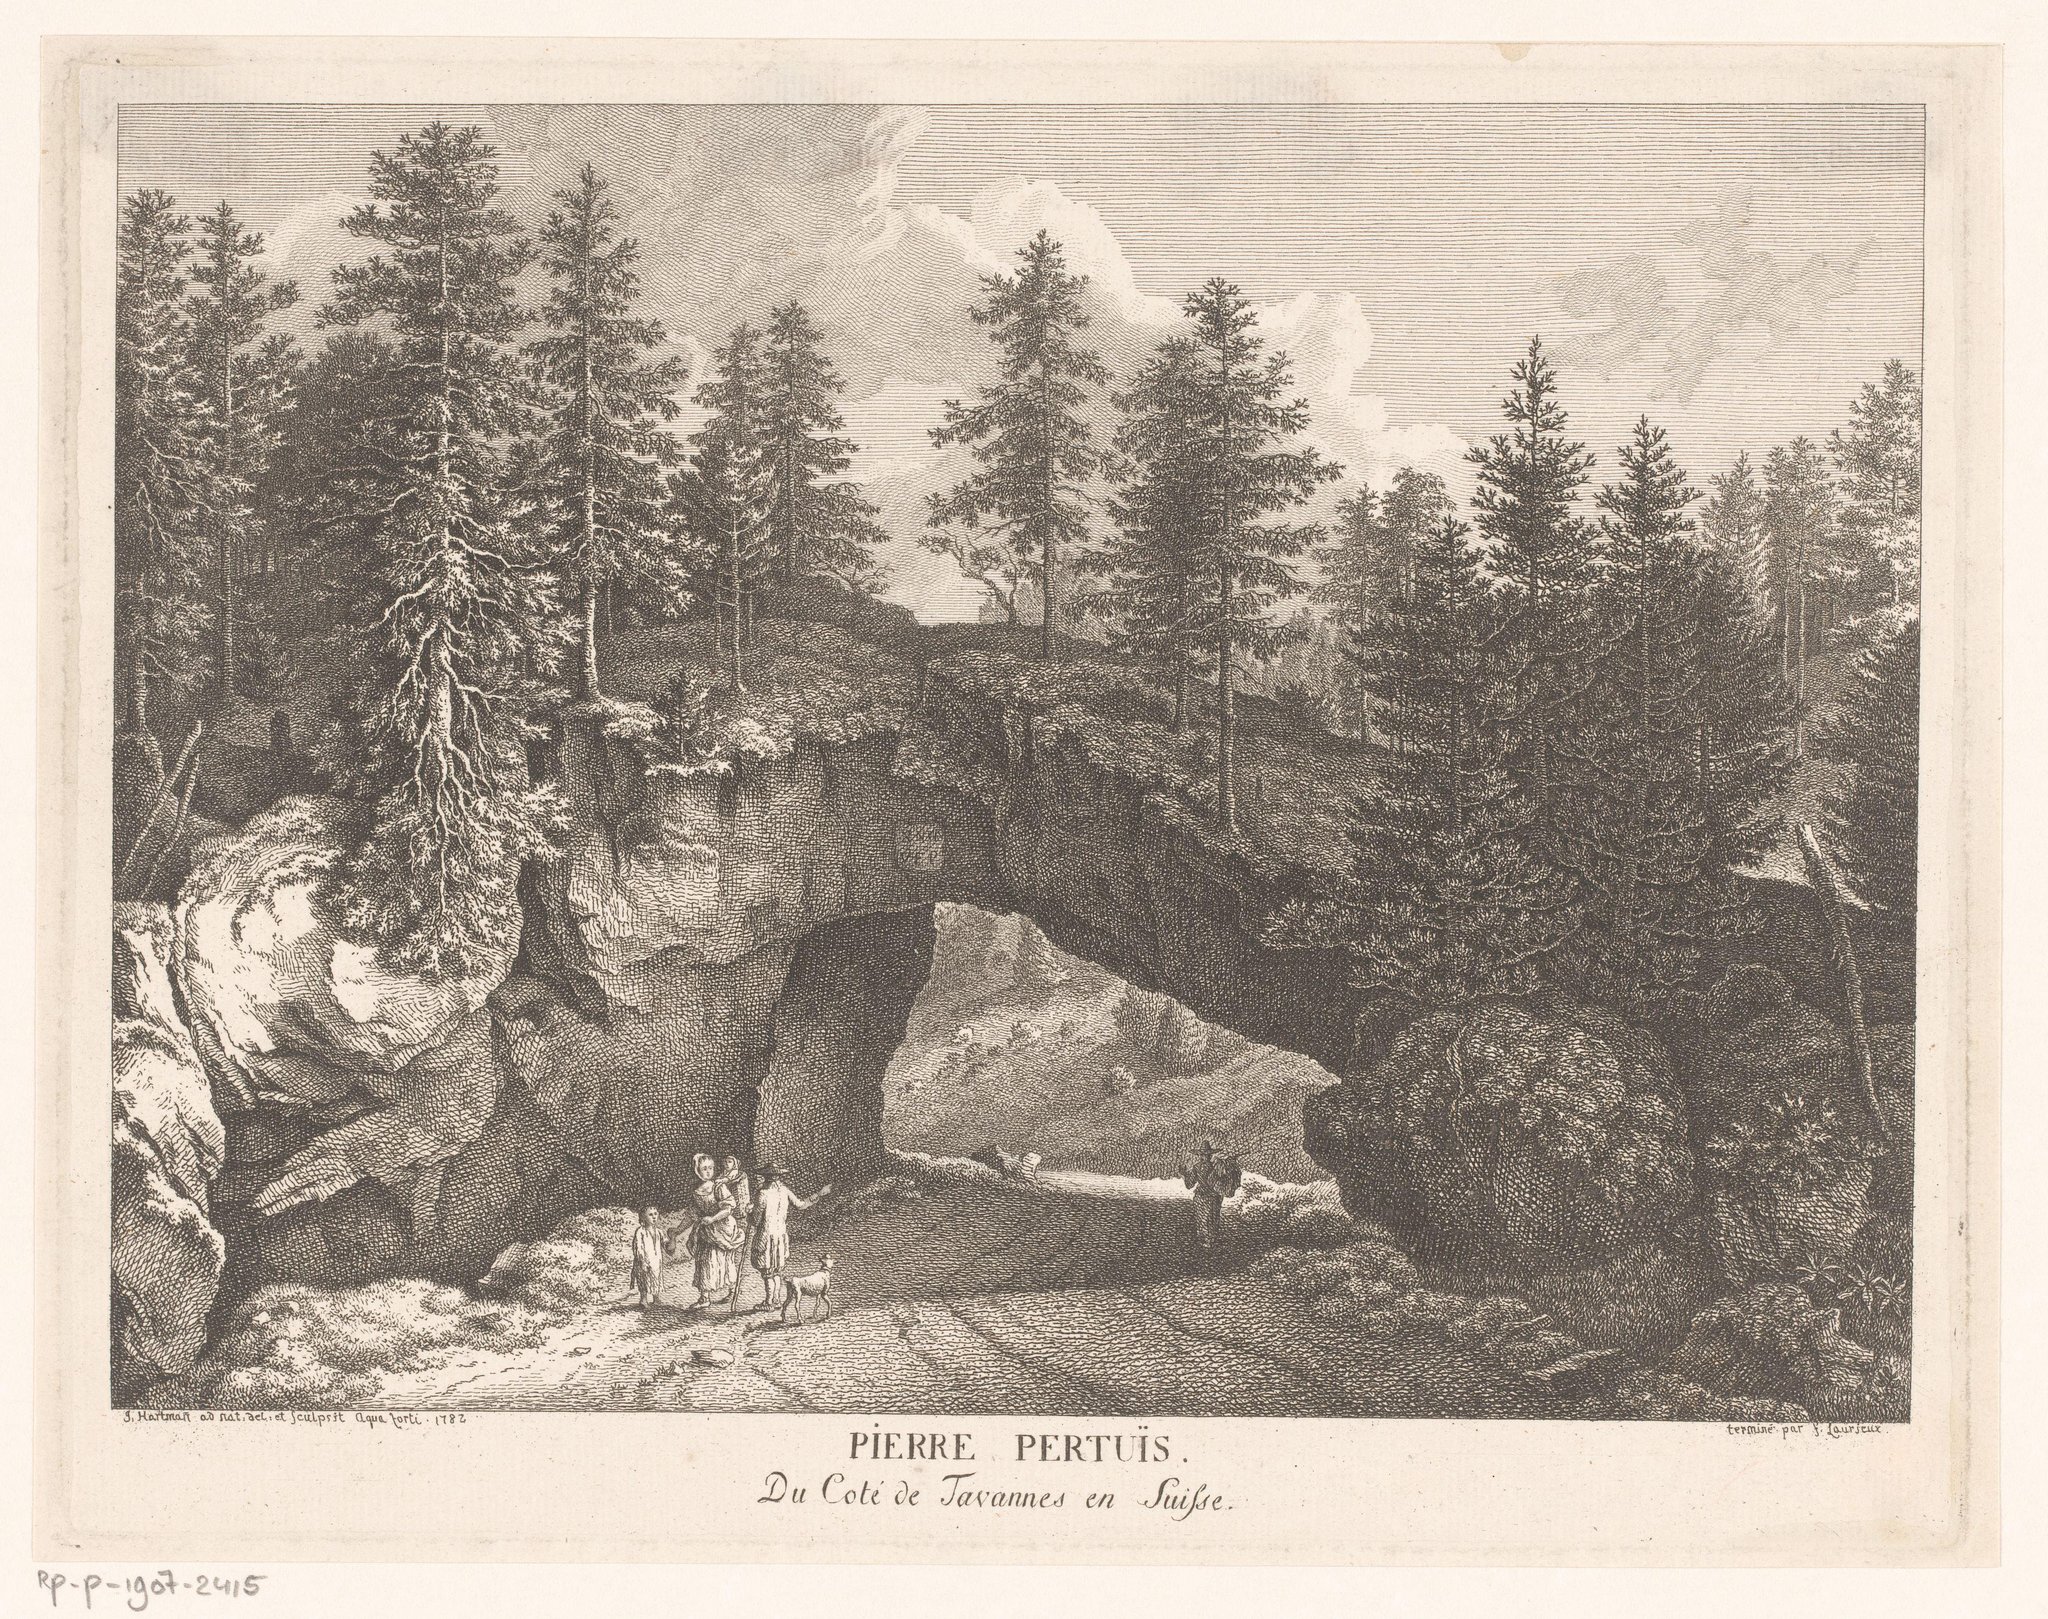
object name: print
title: Gezicht op de Col de Pierre Pertuis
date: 1782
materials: paper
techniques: etching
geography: col de pierre pertuis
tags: rock-formations, 'en route', traveller under way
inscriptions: collector's mark: Lugt 2228